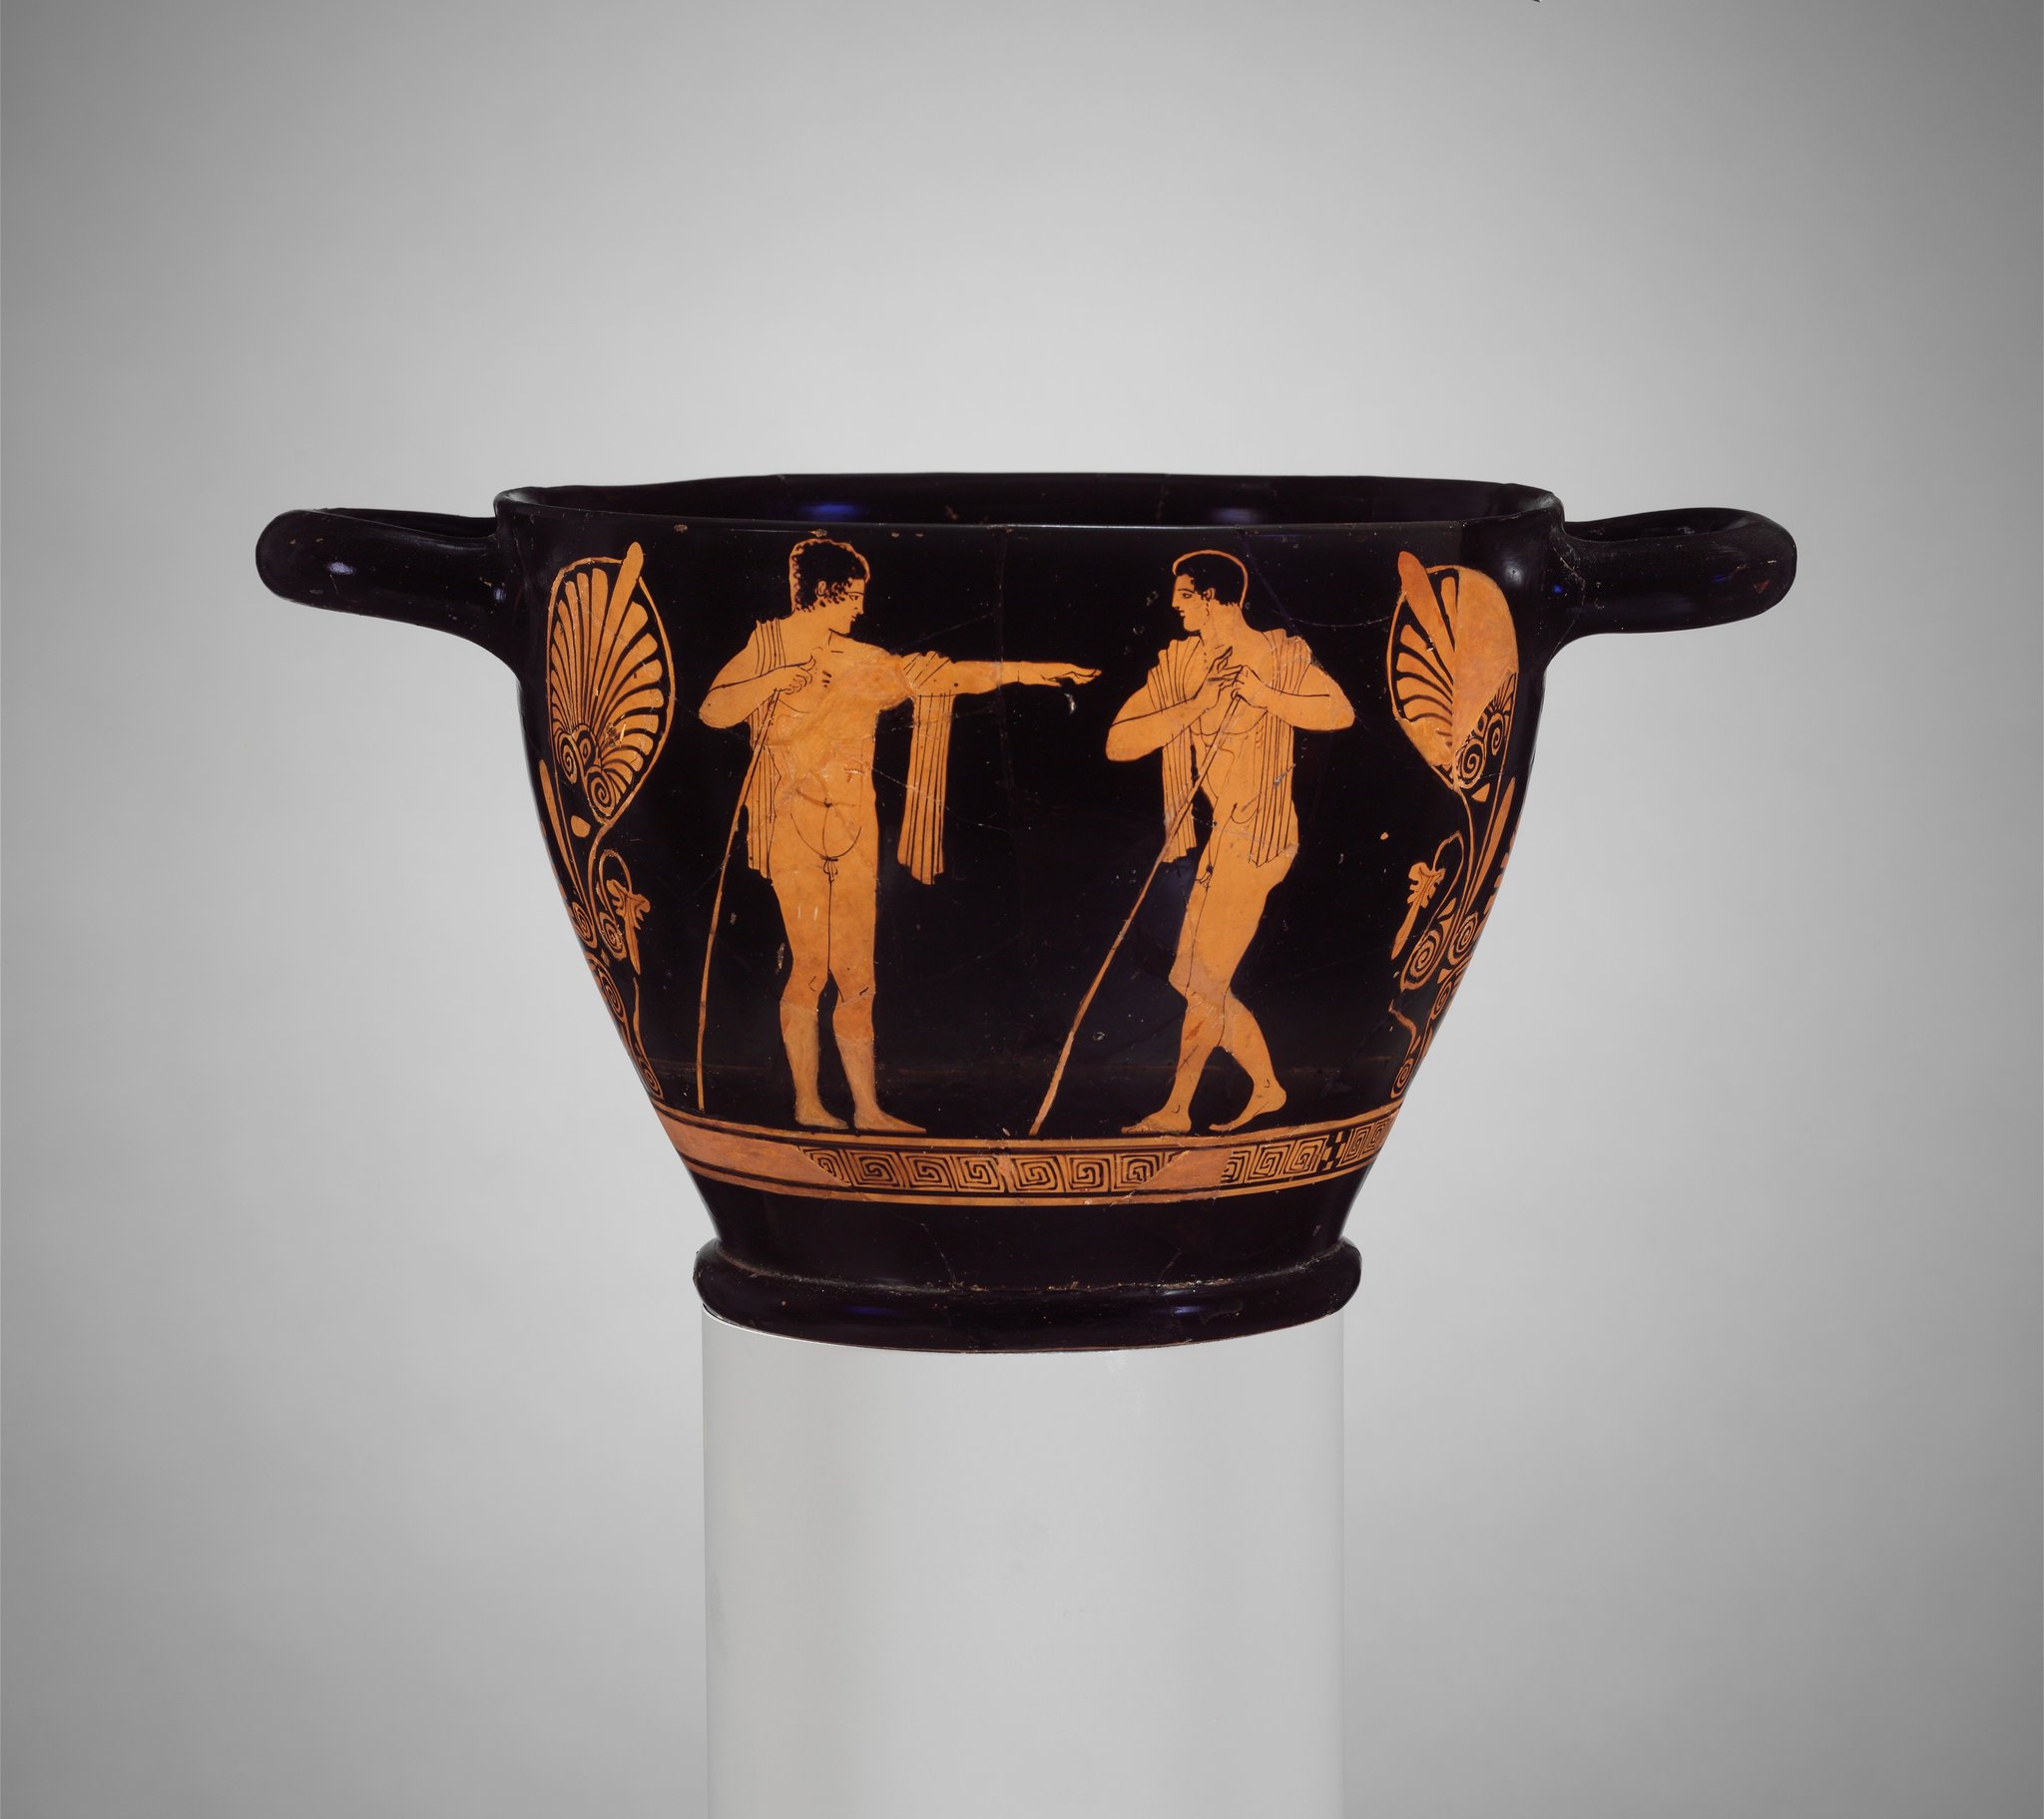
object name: skyphos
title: Terracotta skyphos (deep drinking cup)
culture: greek, attic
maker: painter of london e 777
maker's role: artist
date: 450 BCE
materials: terracotta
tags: men,male nudes